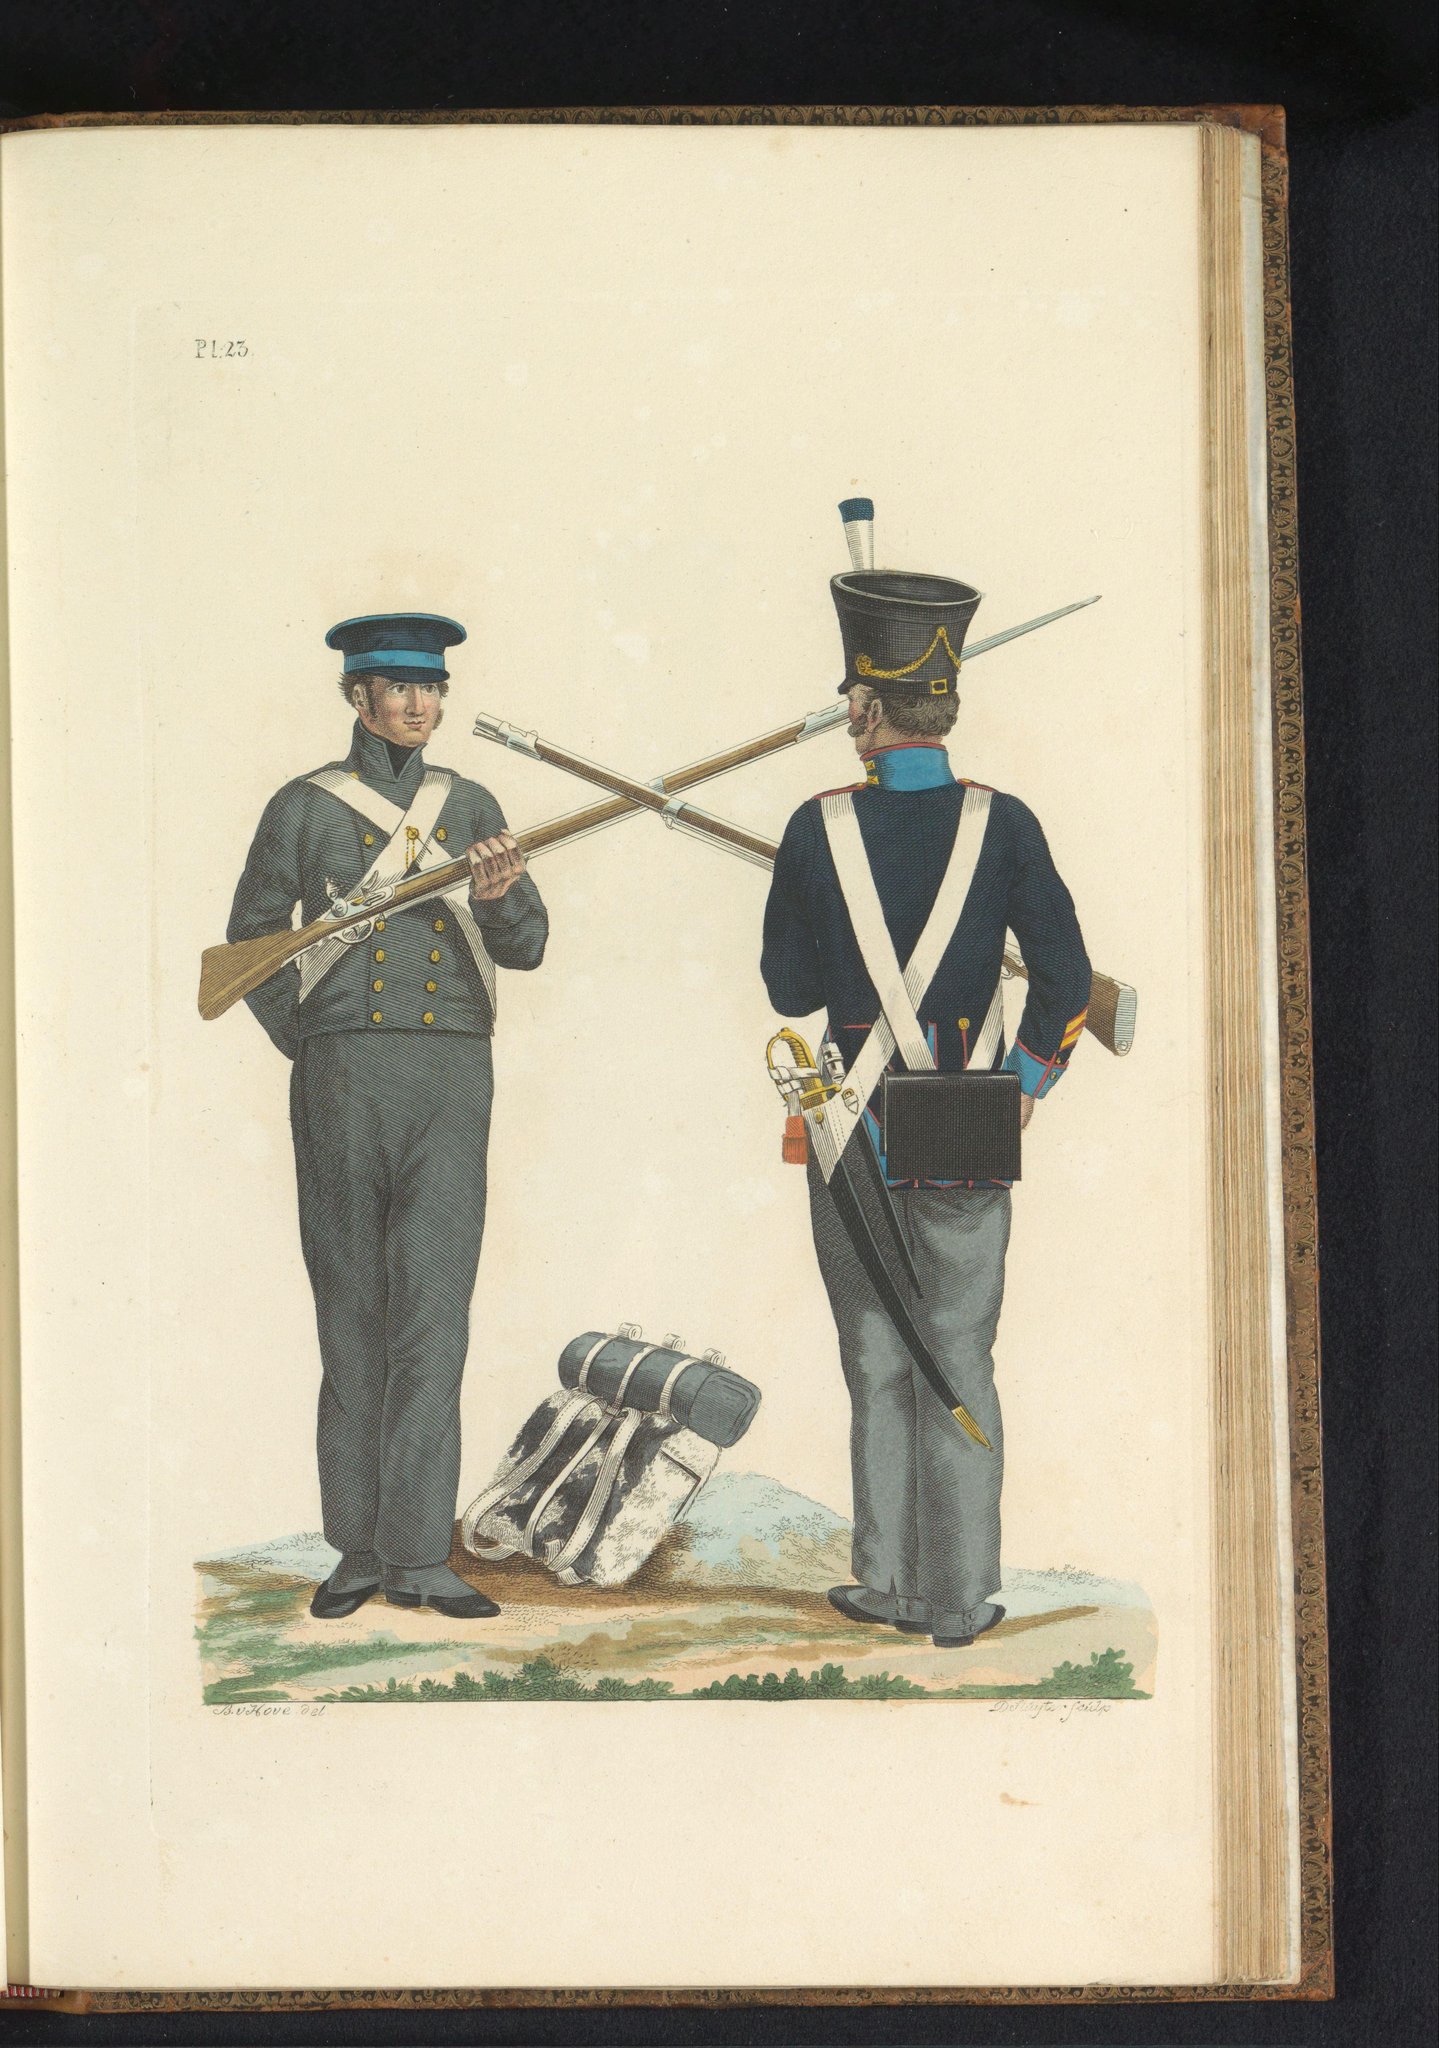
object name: print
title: Korporaal en Fuselier van het Algemeen Depôt der Landmagt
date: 1823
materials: paper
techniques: engraving, etching, hand coloring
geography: netherlands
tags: (military) uniforms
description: Een Nederlandse korporaal en fuselier van het Algemeen Depot van de Landmacht. Met gekruiste geweren. Plaat 23. Uniformvoorstelling in 'Beschrijving hoedanig de Koninklijke Nederlandsche troepen' van J.F. Teupken, 1823.